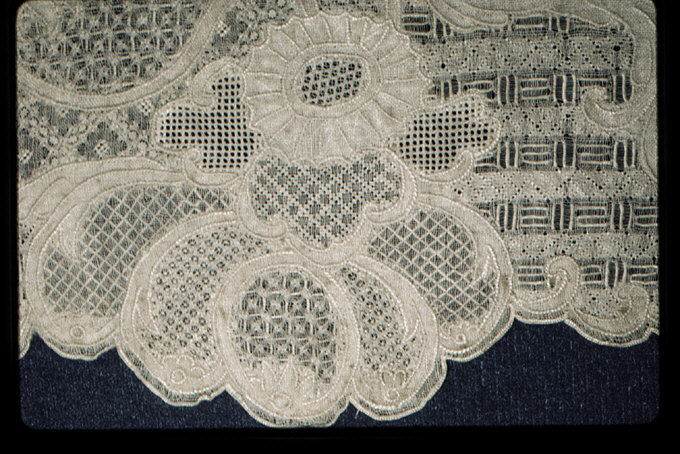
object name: fragment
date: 1750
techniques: embroidery